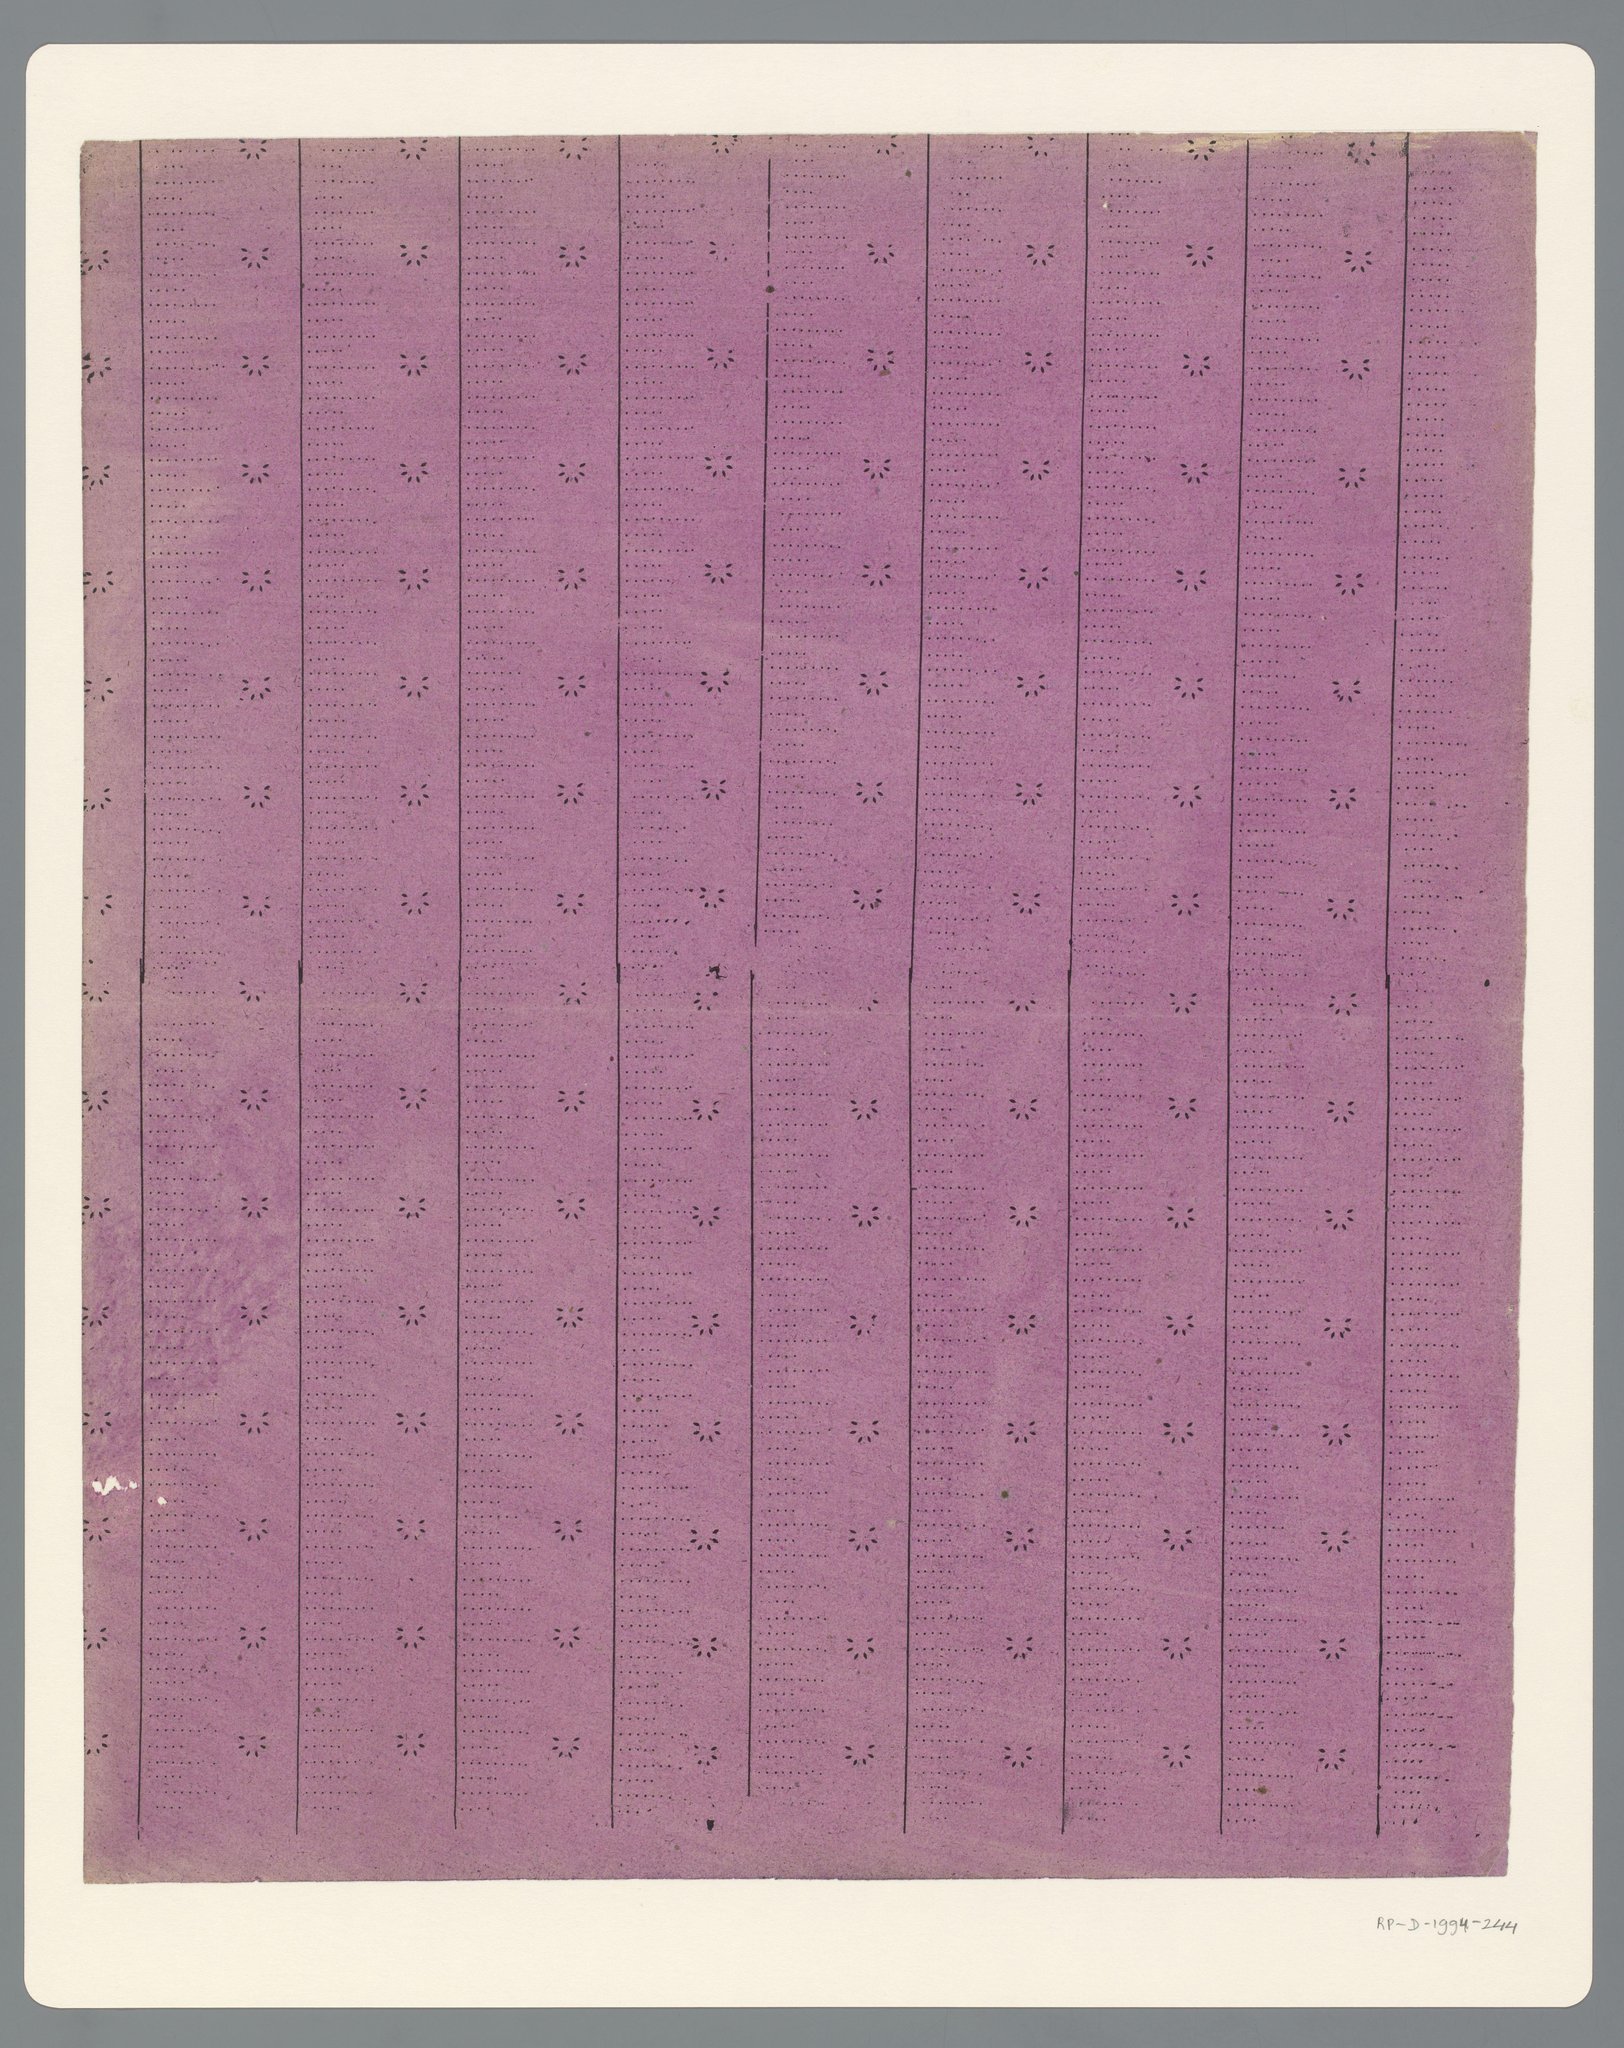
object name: printed paper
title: Blad met verticaal banenpatroon met stippen en bloemmotief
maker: Anonymous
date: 1860-1920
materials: ink, paper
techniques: printing block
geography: aschaffenburg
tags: ornament derived from plant forms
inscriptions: collector's mark: Lugt 2228